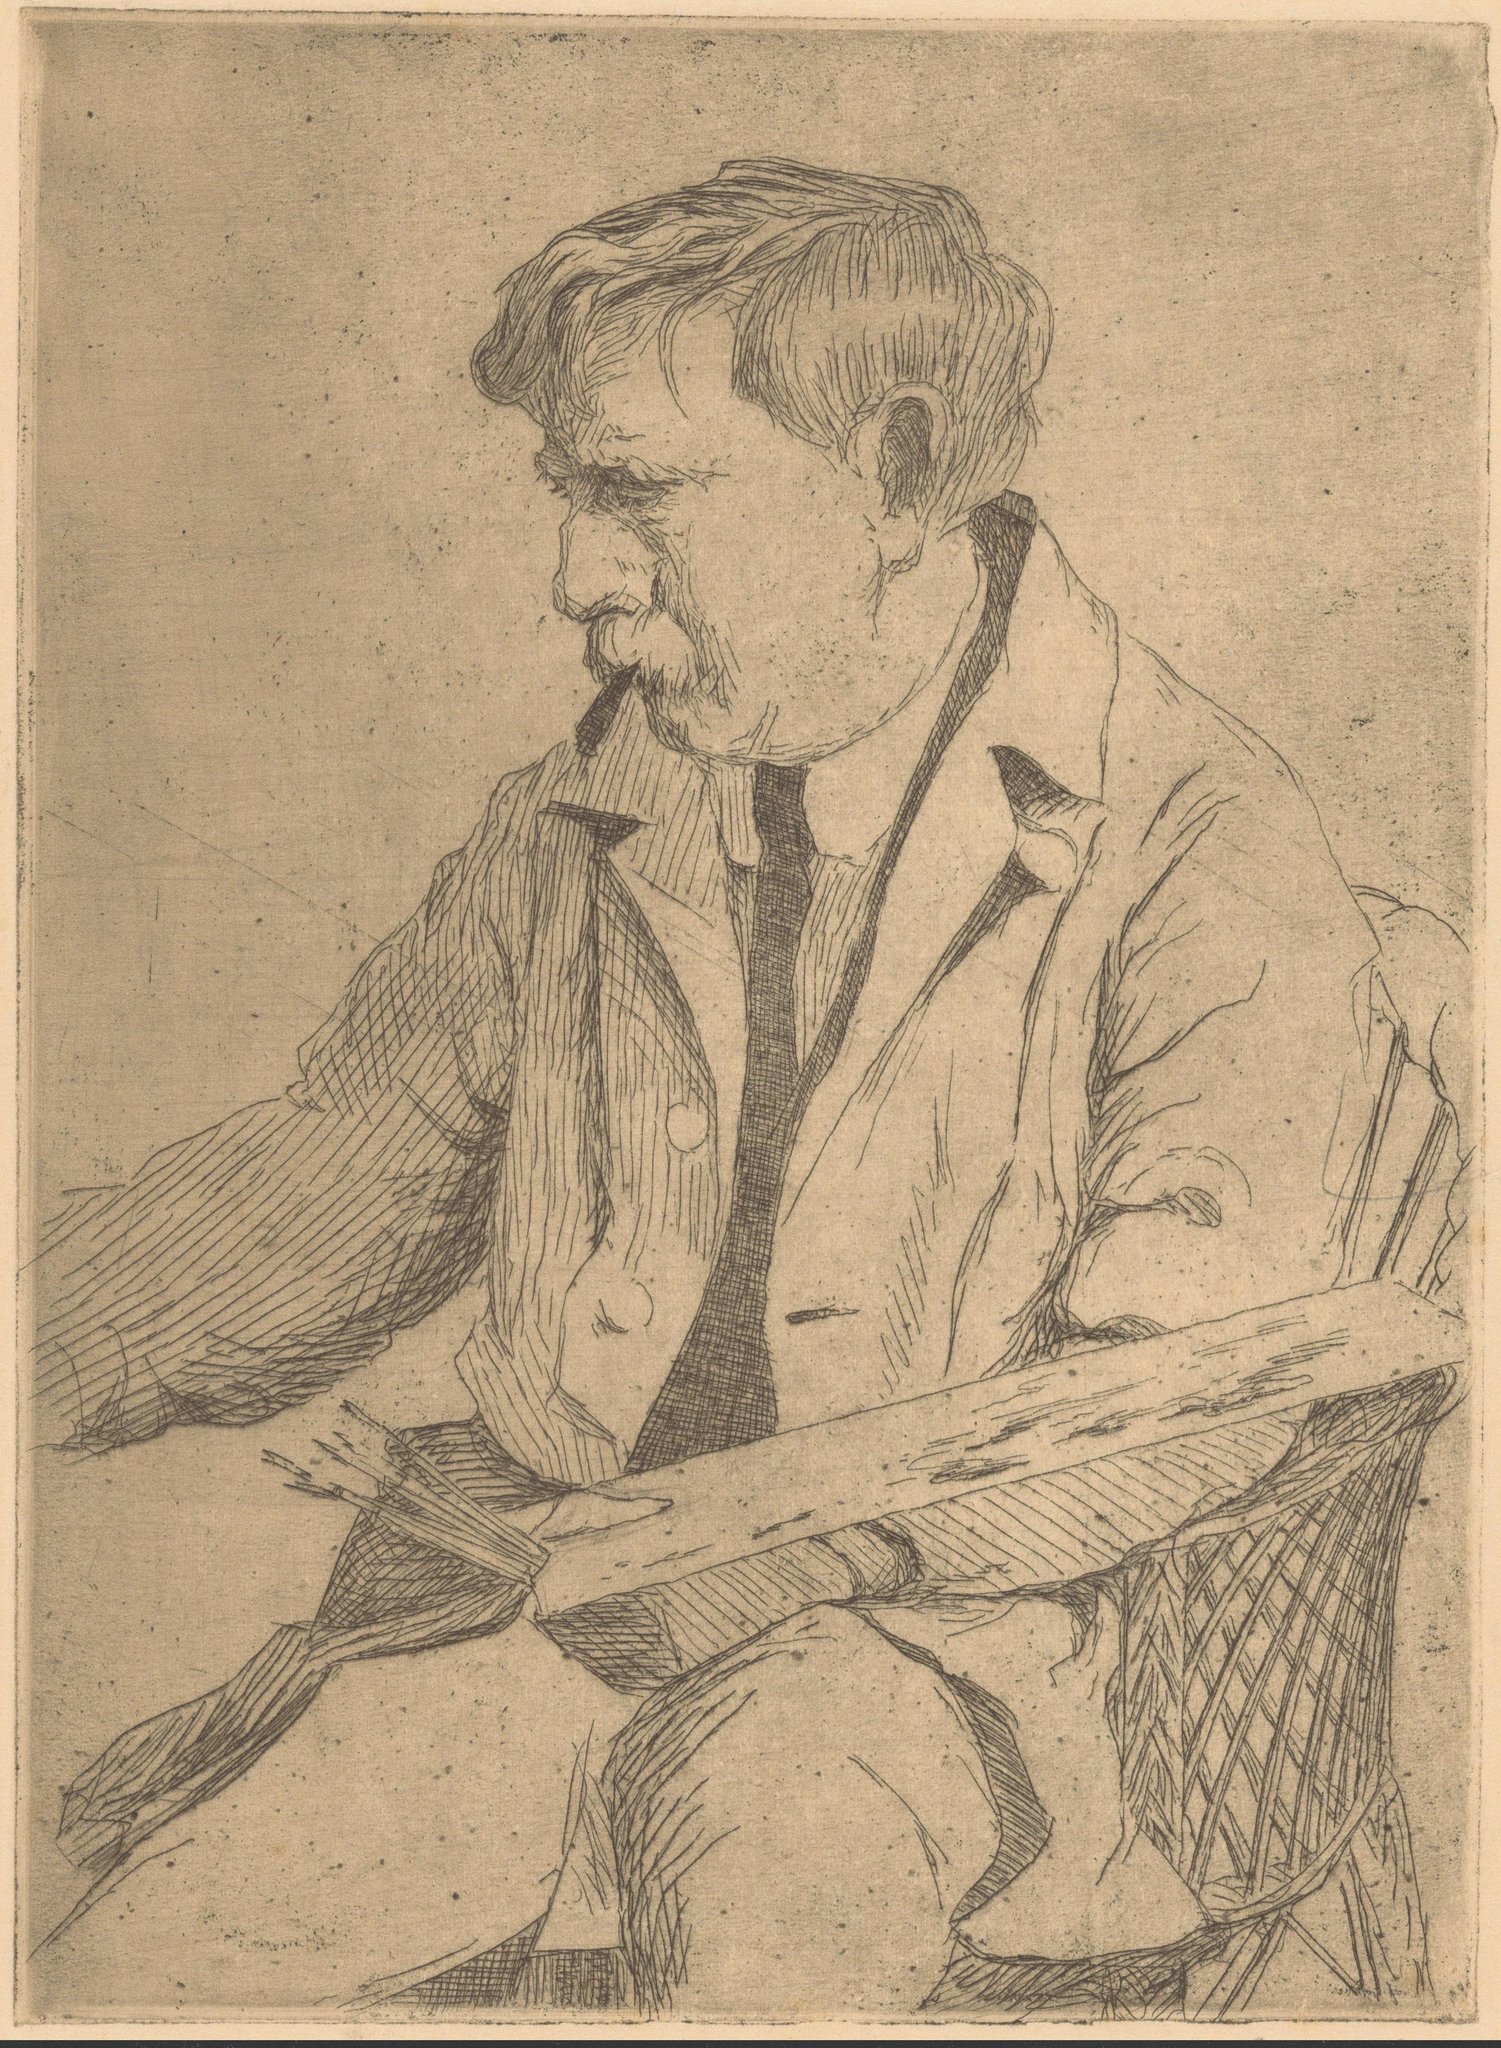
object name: print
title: Portret van Albert Hemelman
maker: johannes henrichs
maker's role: print maker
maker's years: 1882-1954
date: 1892-1954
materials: paper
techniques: etching, intaglio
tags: amsterdam, print maker, draughtsman, albert hemelman, portrait, self-portrait of painter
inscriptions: collector's mark: Lugt 2228, collector's mark: Lugt 2760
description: Een portret van de kunstenaar Albert Hemelman met een schildersezel in zijn hand. Op verso een krijttekening van een schaal.